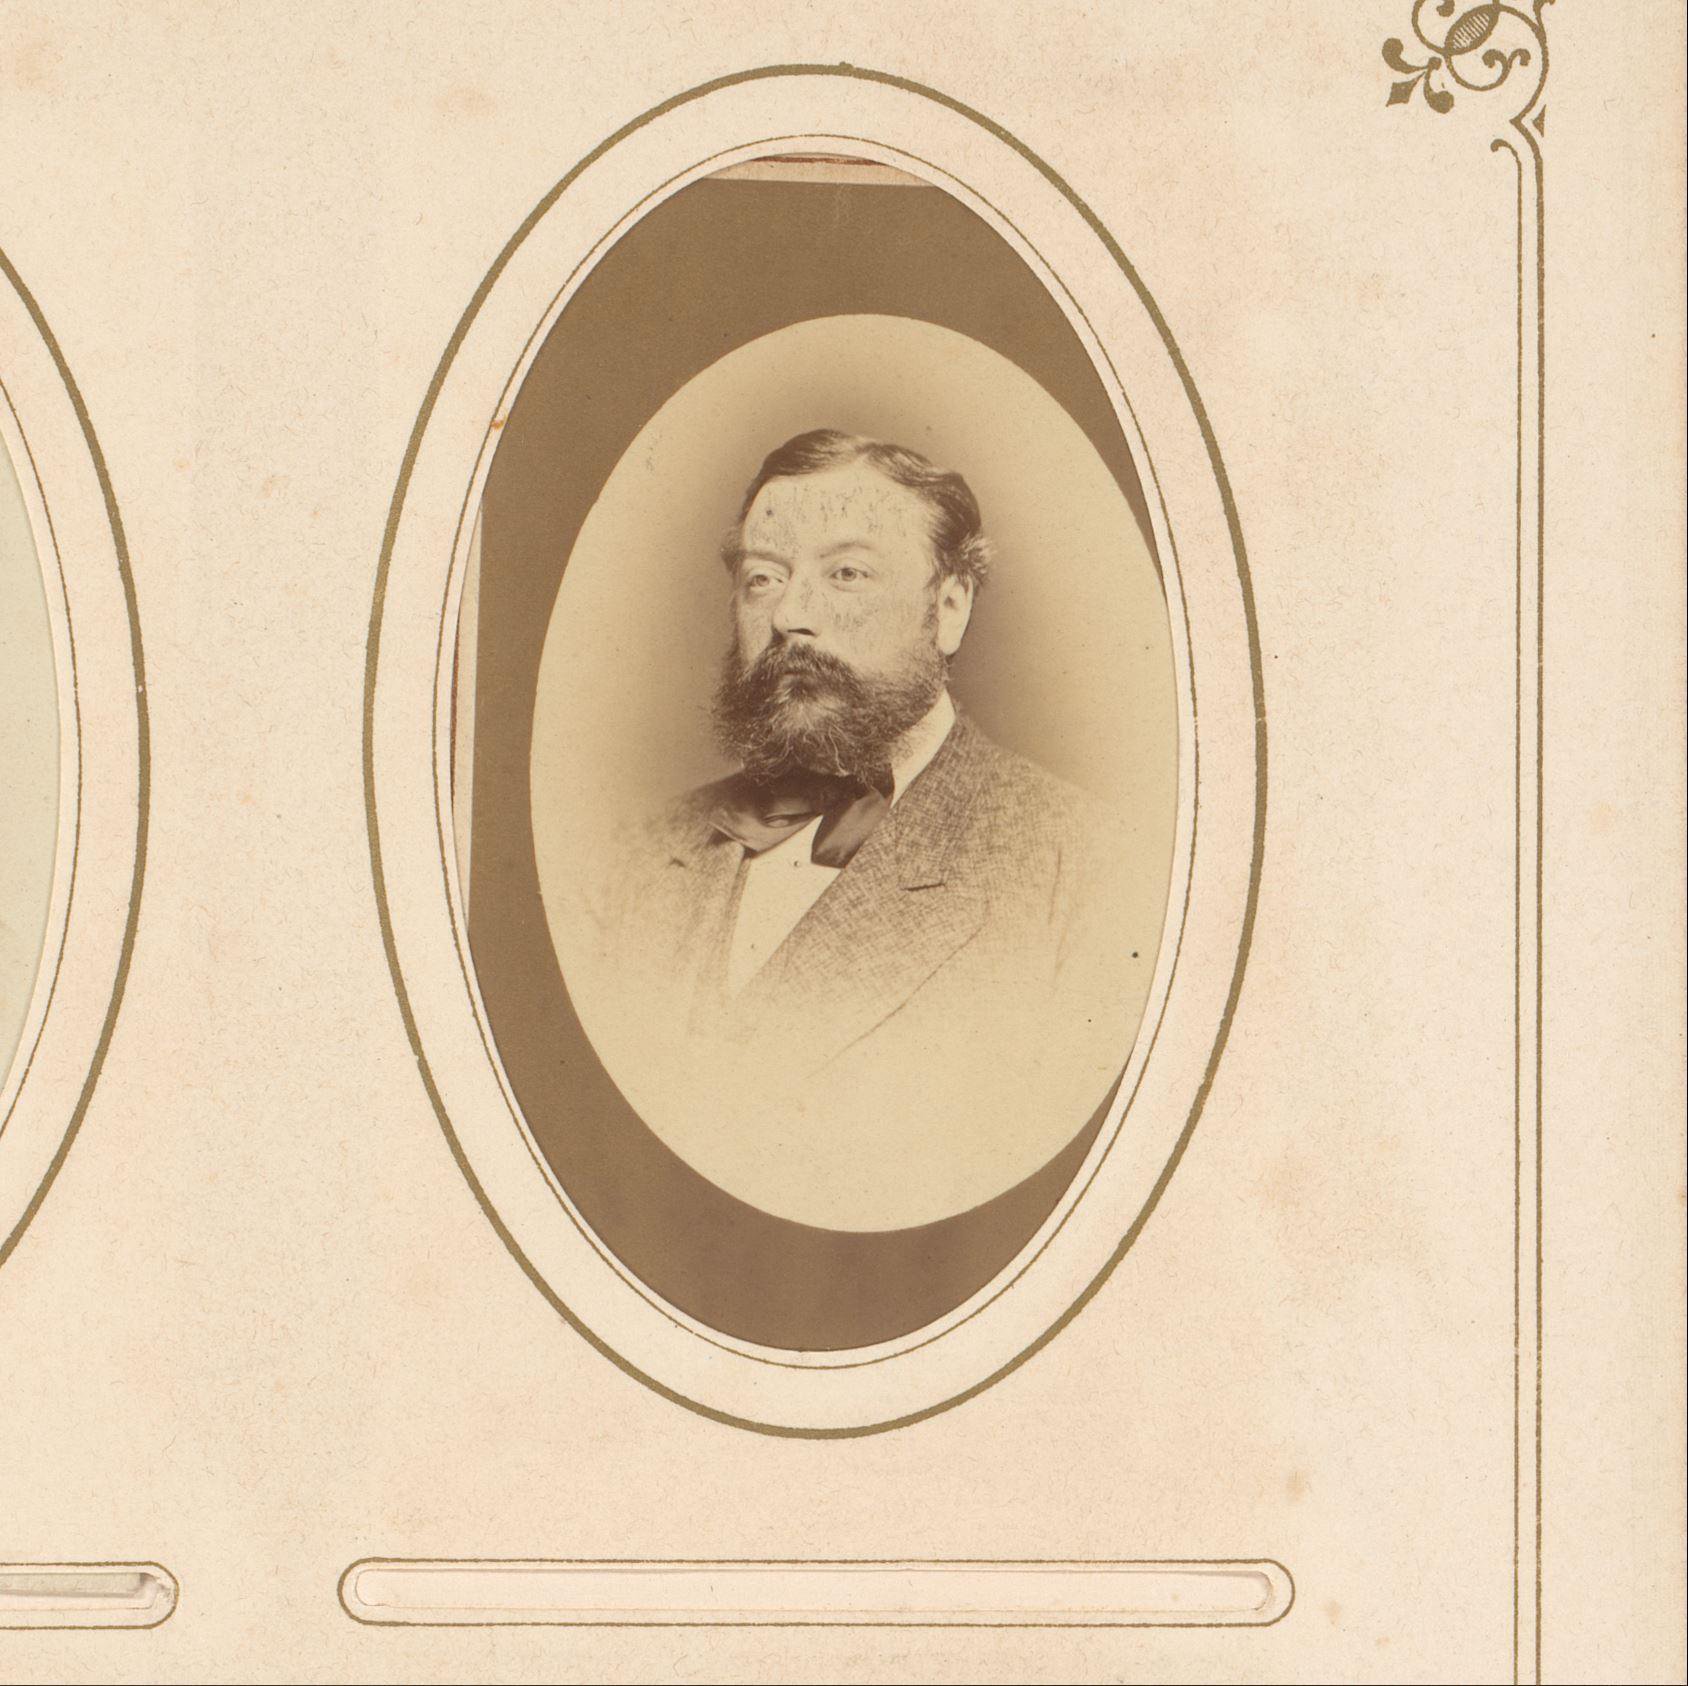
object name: photograph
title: Portret van een man met baard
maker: f.e. perger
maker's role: fotograaf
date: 1850-1900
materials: cardboard, photographic support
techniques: albumen print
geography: bad ems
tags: historical persons, beard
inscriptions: inscription: ‘Artistische Anstalt/ für/ Photographie/ von/ F. E. Perger/ in/ BAD EMS/ Haus Kaiser Alexander.’